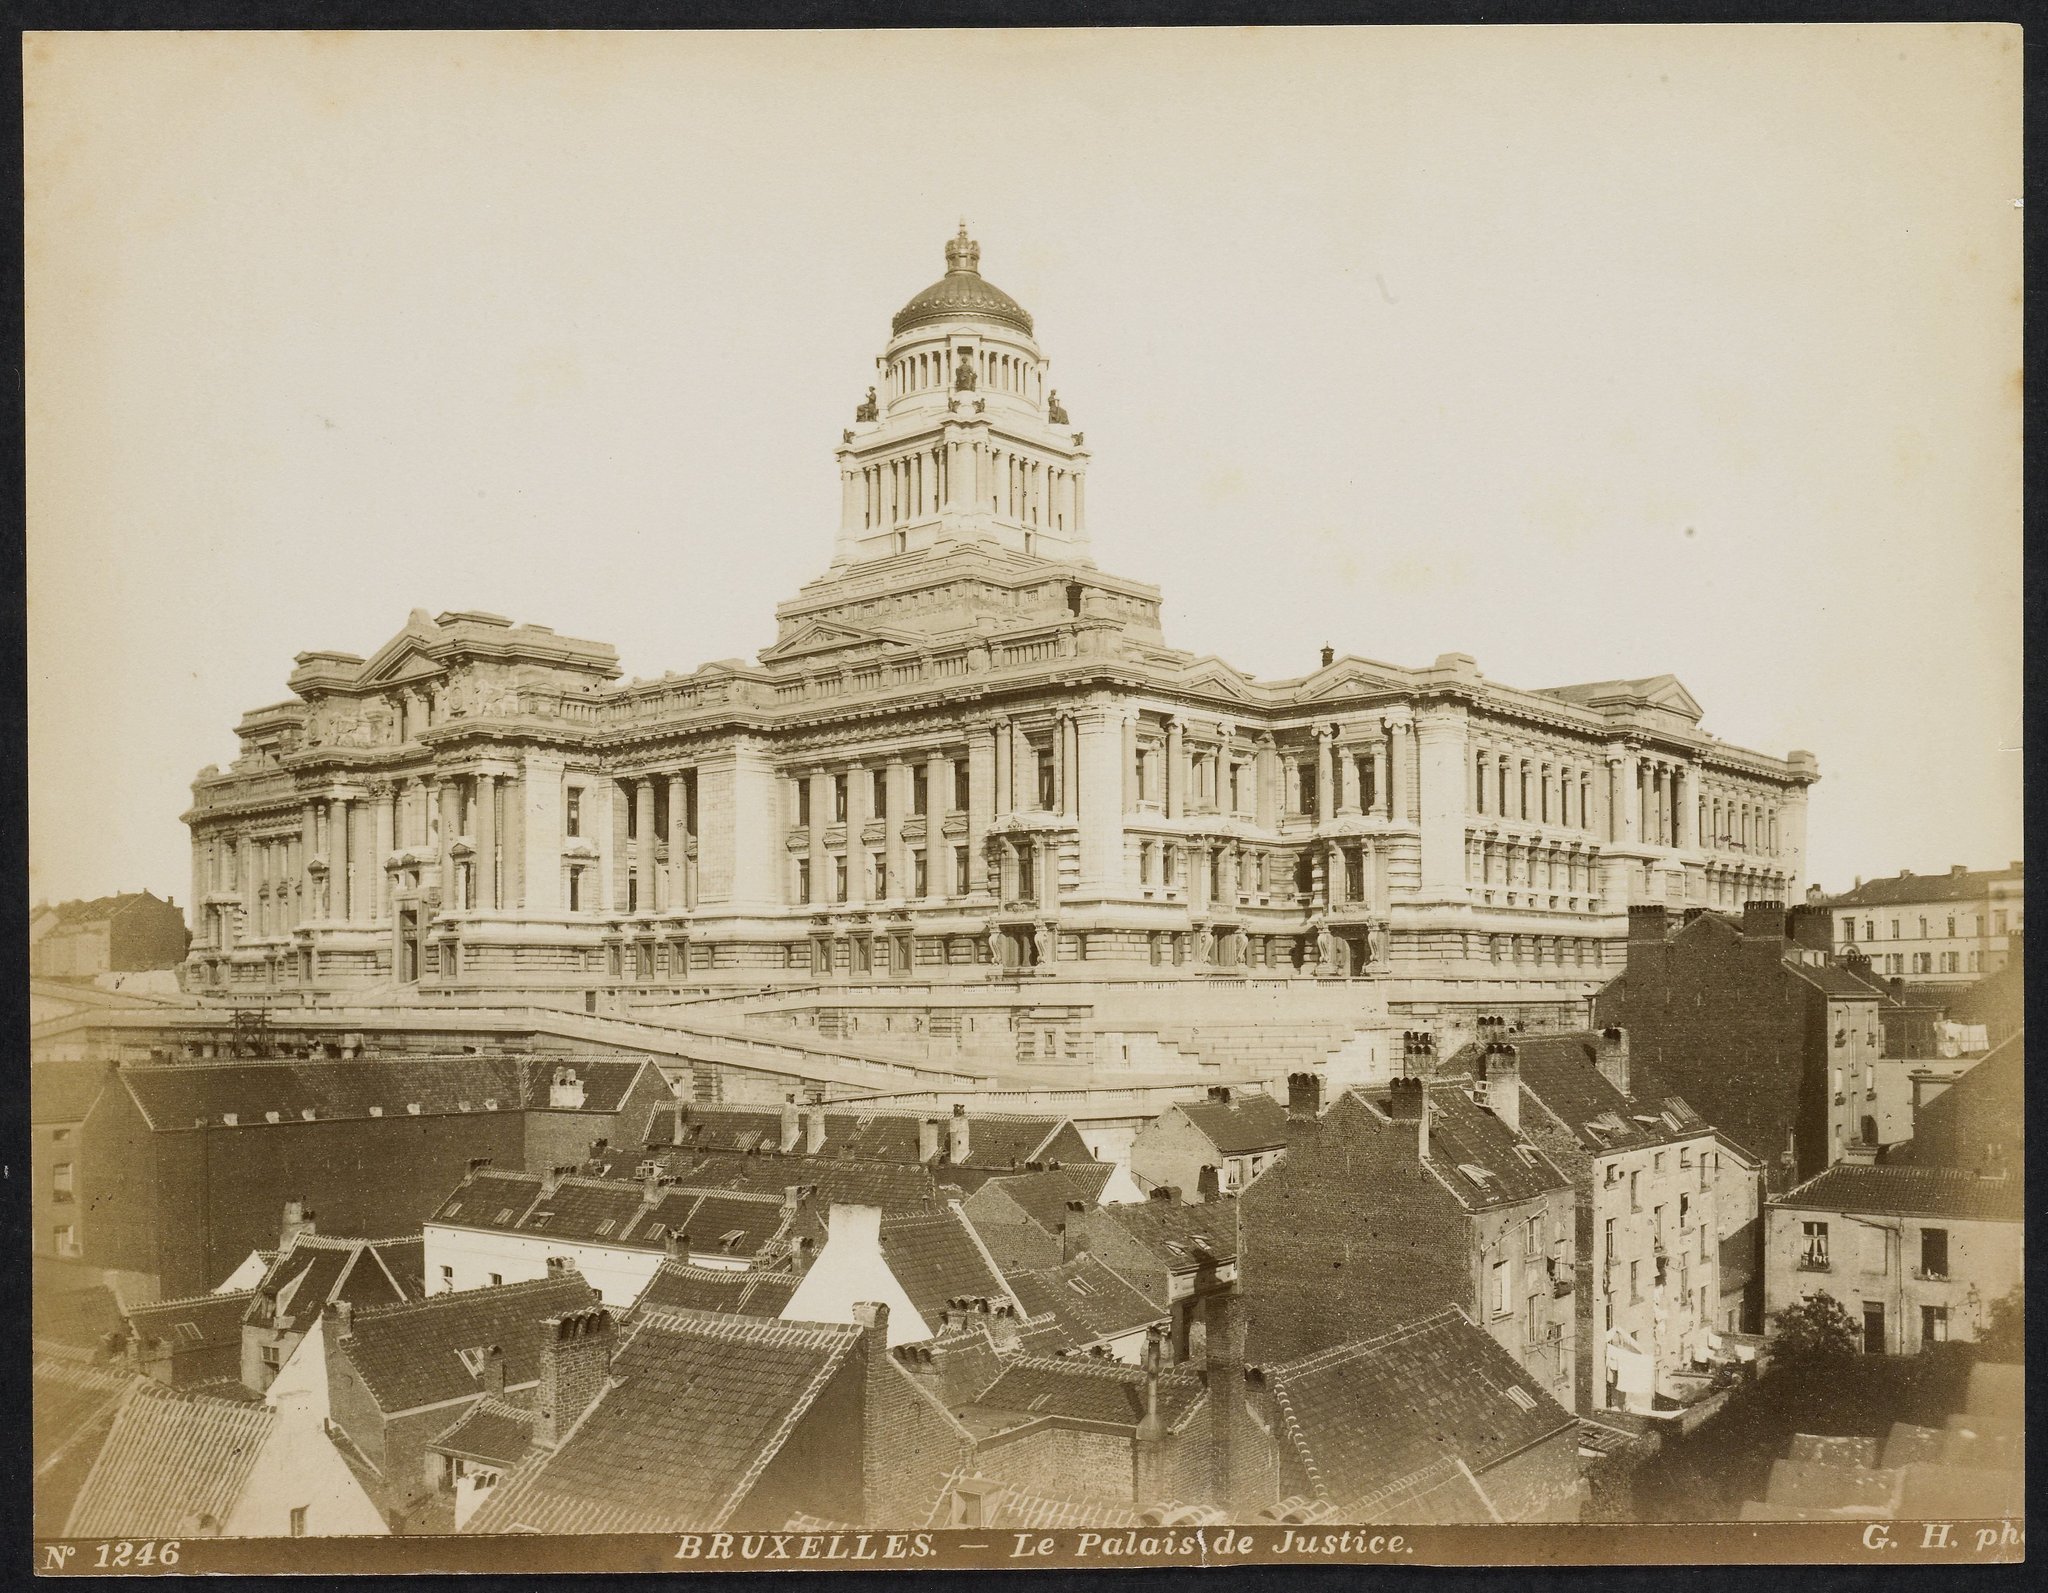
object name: photograph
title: Bruxelles-Le Palais de Justice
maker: gustave hermans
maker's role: publisher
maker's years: 1856-1934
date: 1884-1914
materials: paper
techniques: albumen print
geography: brussels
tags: court building, exterior ~ representation of a building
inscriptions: number: ‘No 1246’